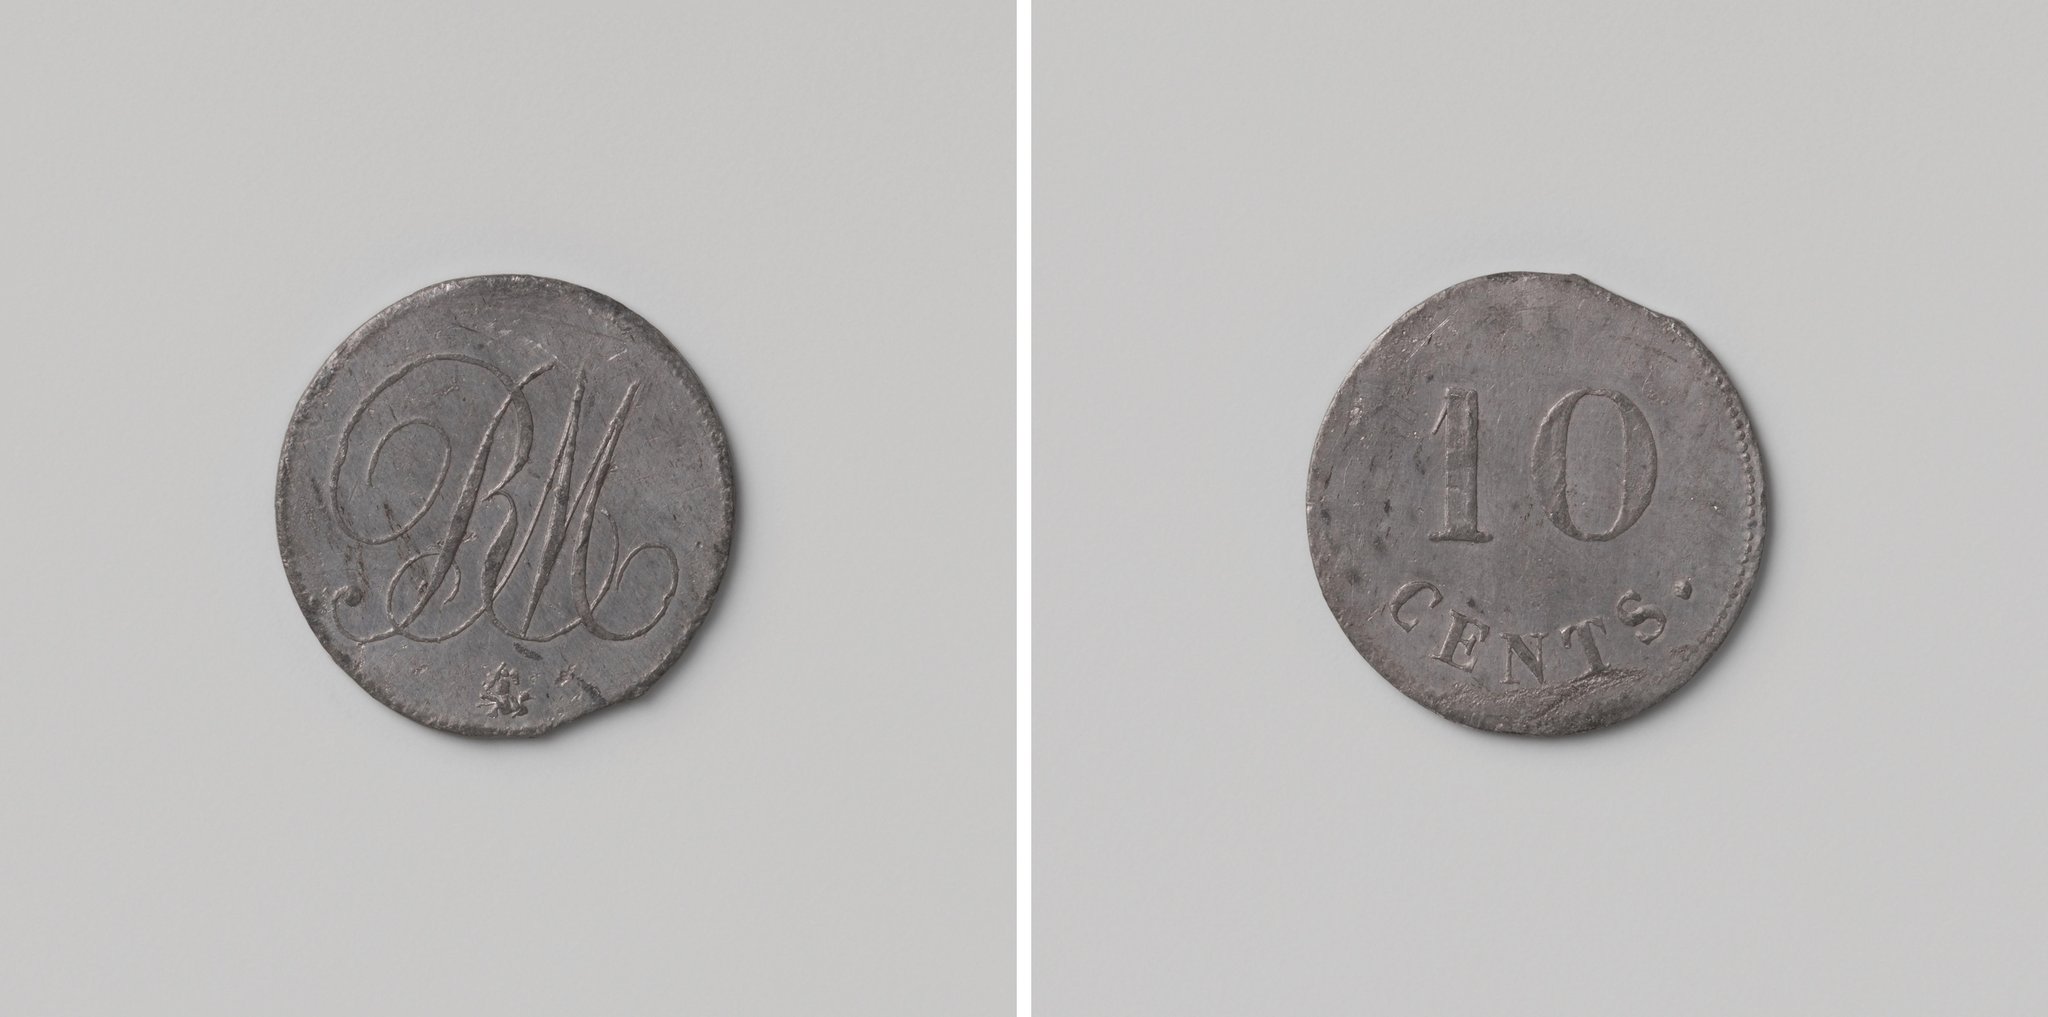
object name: medal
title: Huismunt van de kolonies Rijkevorsel en Merksplas ter waarde van tien cent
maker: Anonymous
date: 1823-1839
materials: zinc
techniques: striking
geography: brussels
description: Zinken munt. Voorzijde: monogram van letters R en M boven merktekentje. Keerzijde: waardeaanduiding